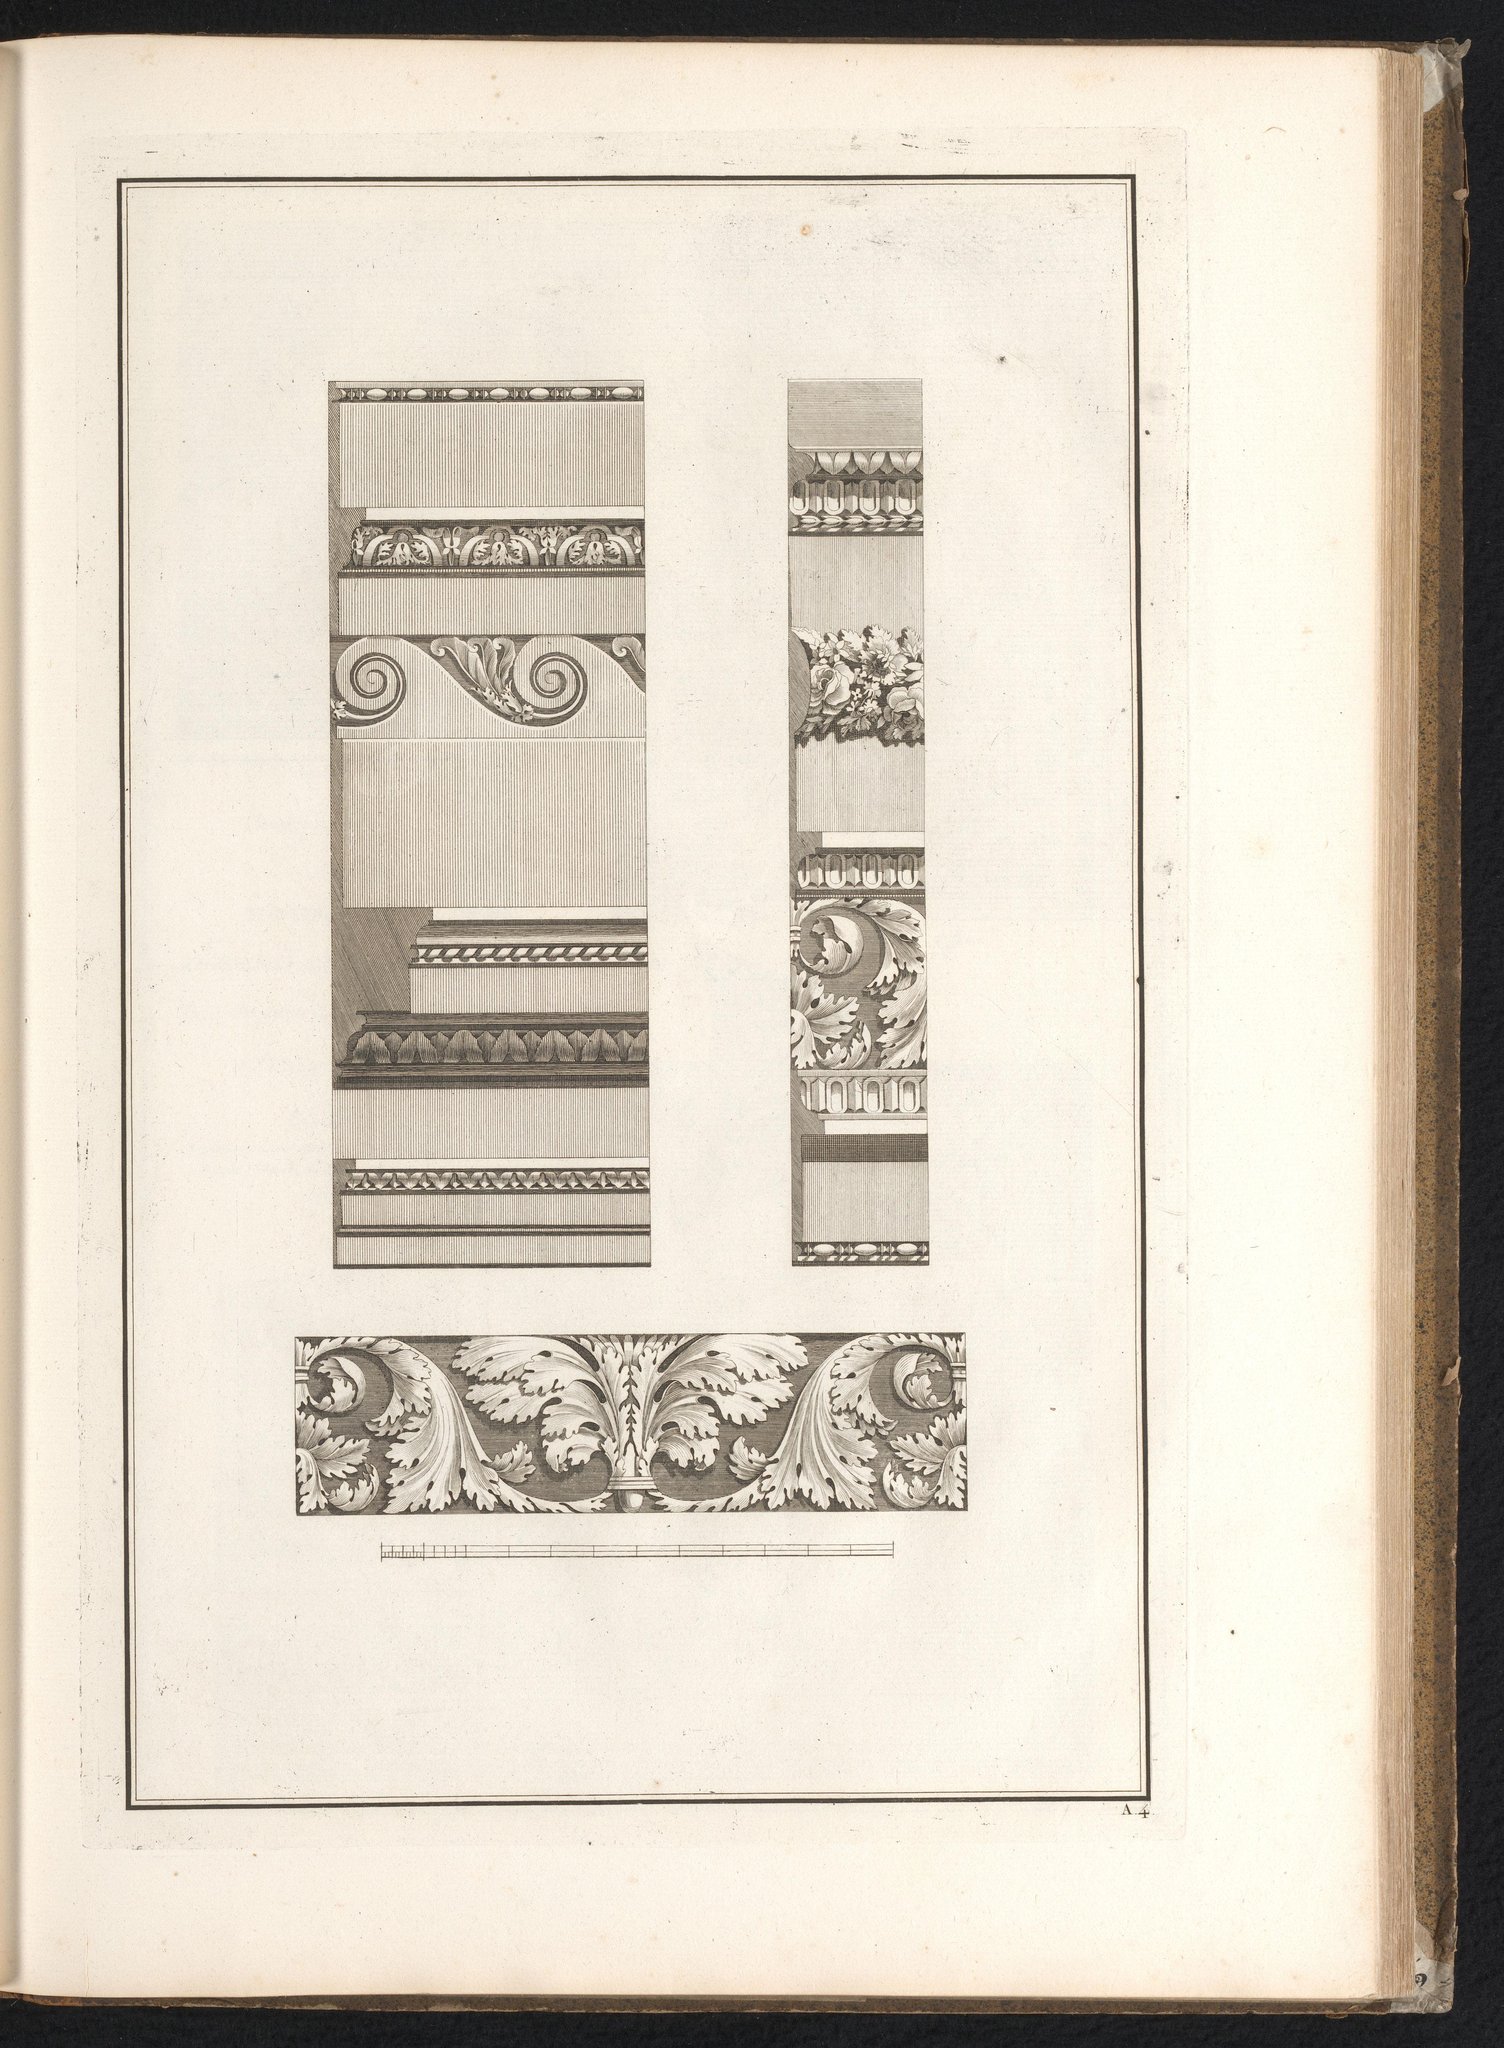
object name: ornament print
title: Modèles de plafonds, corniches, profils, fragments et détails d'ornements, tirés des plus beaux edifices modernes d'Italie : premier cahier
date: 1792-1802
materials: paper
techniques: engraving, etching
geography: paris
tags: decorations (interior of the house), ornament derived from plant forms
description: Doordat dit album bestaat uit meerdere, deels eerder uitgegeven prentreeksen, is de datering niet consequent. Het geheel is op de titelpagina gedateerd op 1802. Deze reeks is gedateerd 1792. Aangezien onduidelijk is wanneer de prenten in deze vorm precies uitgegeven zijn, worden beide data gehanteerd: zowel 1802 als publicatiedatum, en de eerdere datum. De serietitel voor het gehele werk is "Recueil d'arabesques, contenant les loges du Vatican". De andere serietitel is de titel van de specifieke reeks binnen het geheel.